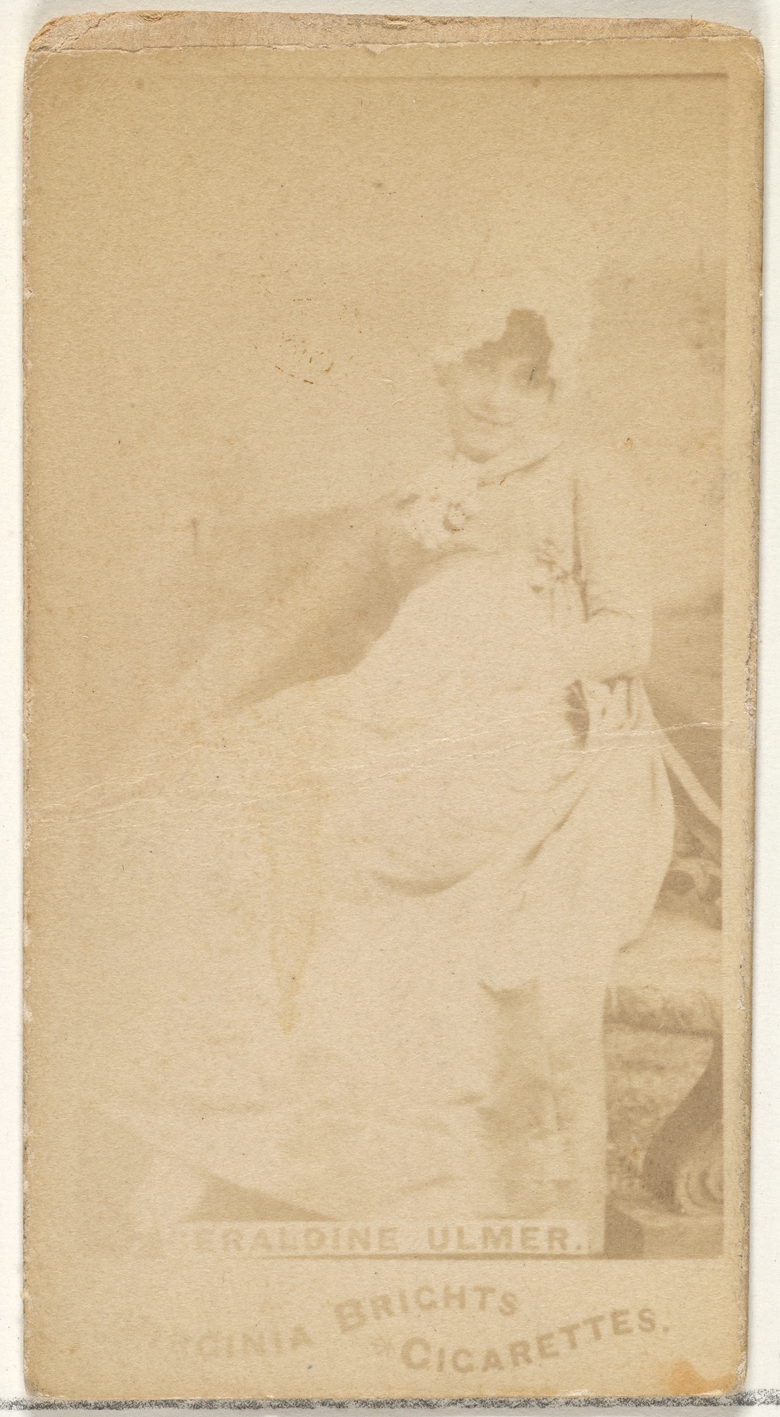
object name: photograph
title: Geraldine Ulmer, from the Actors and Actresses series (N45, Type 1) for Virginia Brights Cigarettes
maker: allen & ginter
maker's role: publisher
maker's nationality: american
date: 1888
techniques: albumen silver print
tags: portraits,women,actresses